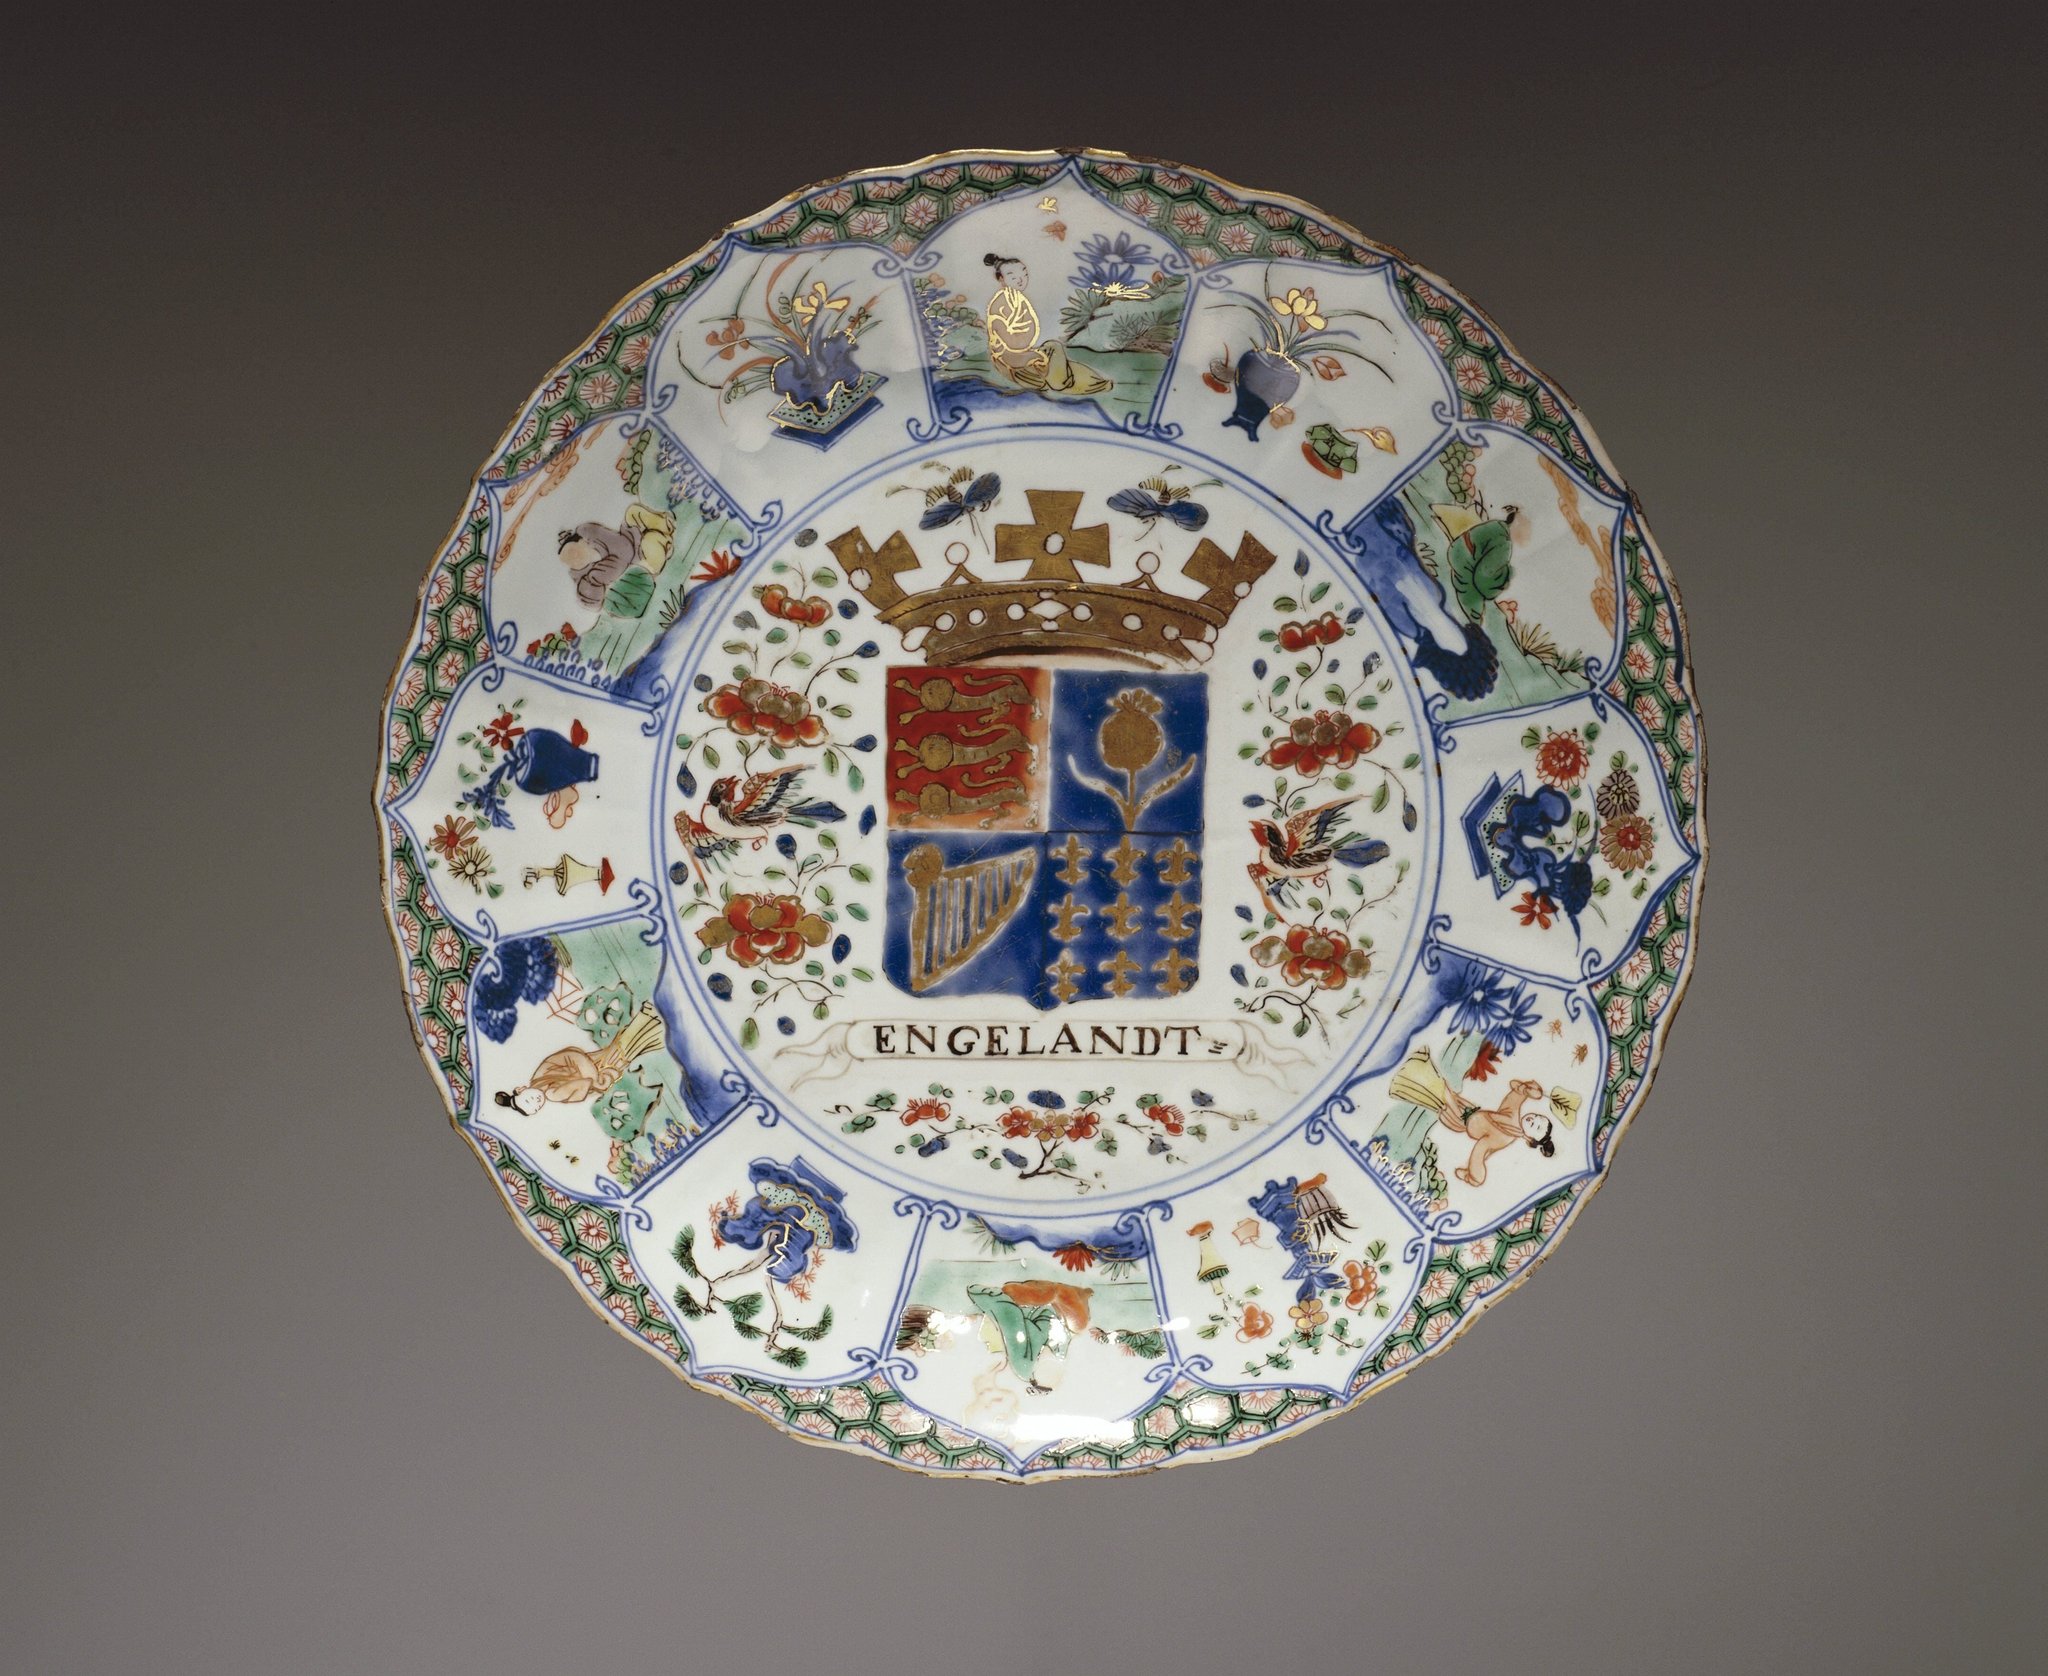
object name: platter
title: Saucer-dish with the arms of England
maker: Anonymous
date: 1700-1724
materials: cobalt, glaze, gold, paint, porcelain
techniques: firing, gilding, turning, vitrification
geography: china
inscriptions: inscription: ‘Engelandt’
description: Schotel van porselein met geribde wand en geschulpte rand, beschilderd in onderglazuur blauw en op het glazuur blauw, rood, groen, geel, zwart en goud. Op het plat in een medaillon het wapen van Engeland met daaronder het opschrift 'Engelandt', om het wapen bloemtakken, twee vlinders en twee vogels. De wand is verdeeld in twaalf bloembladvormige vakken met afwisselend een bloemenvaas en een persoon in een landschap; tussen de vakken servetwerk. De achterzijde met twee bloemtakken. Een barst in de wand. Wapenporselein met famille verte emailkleuren.